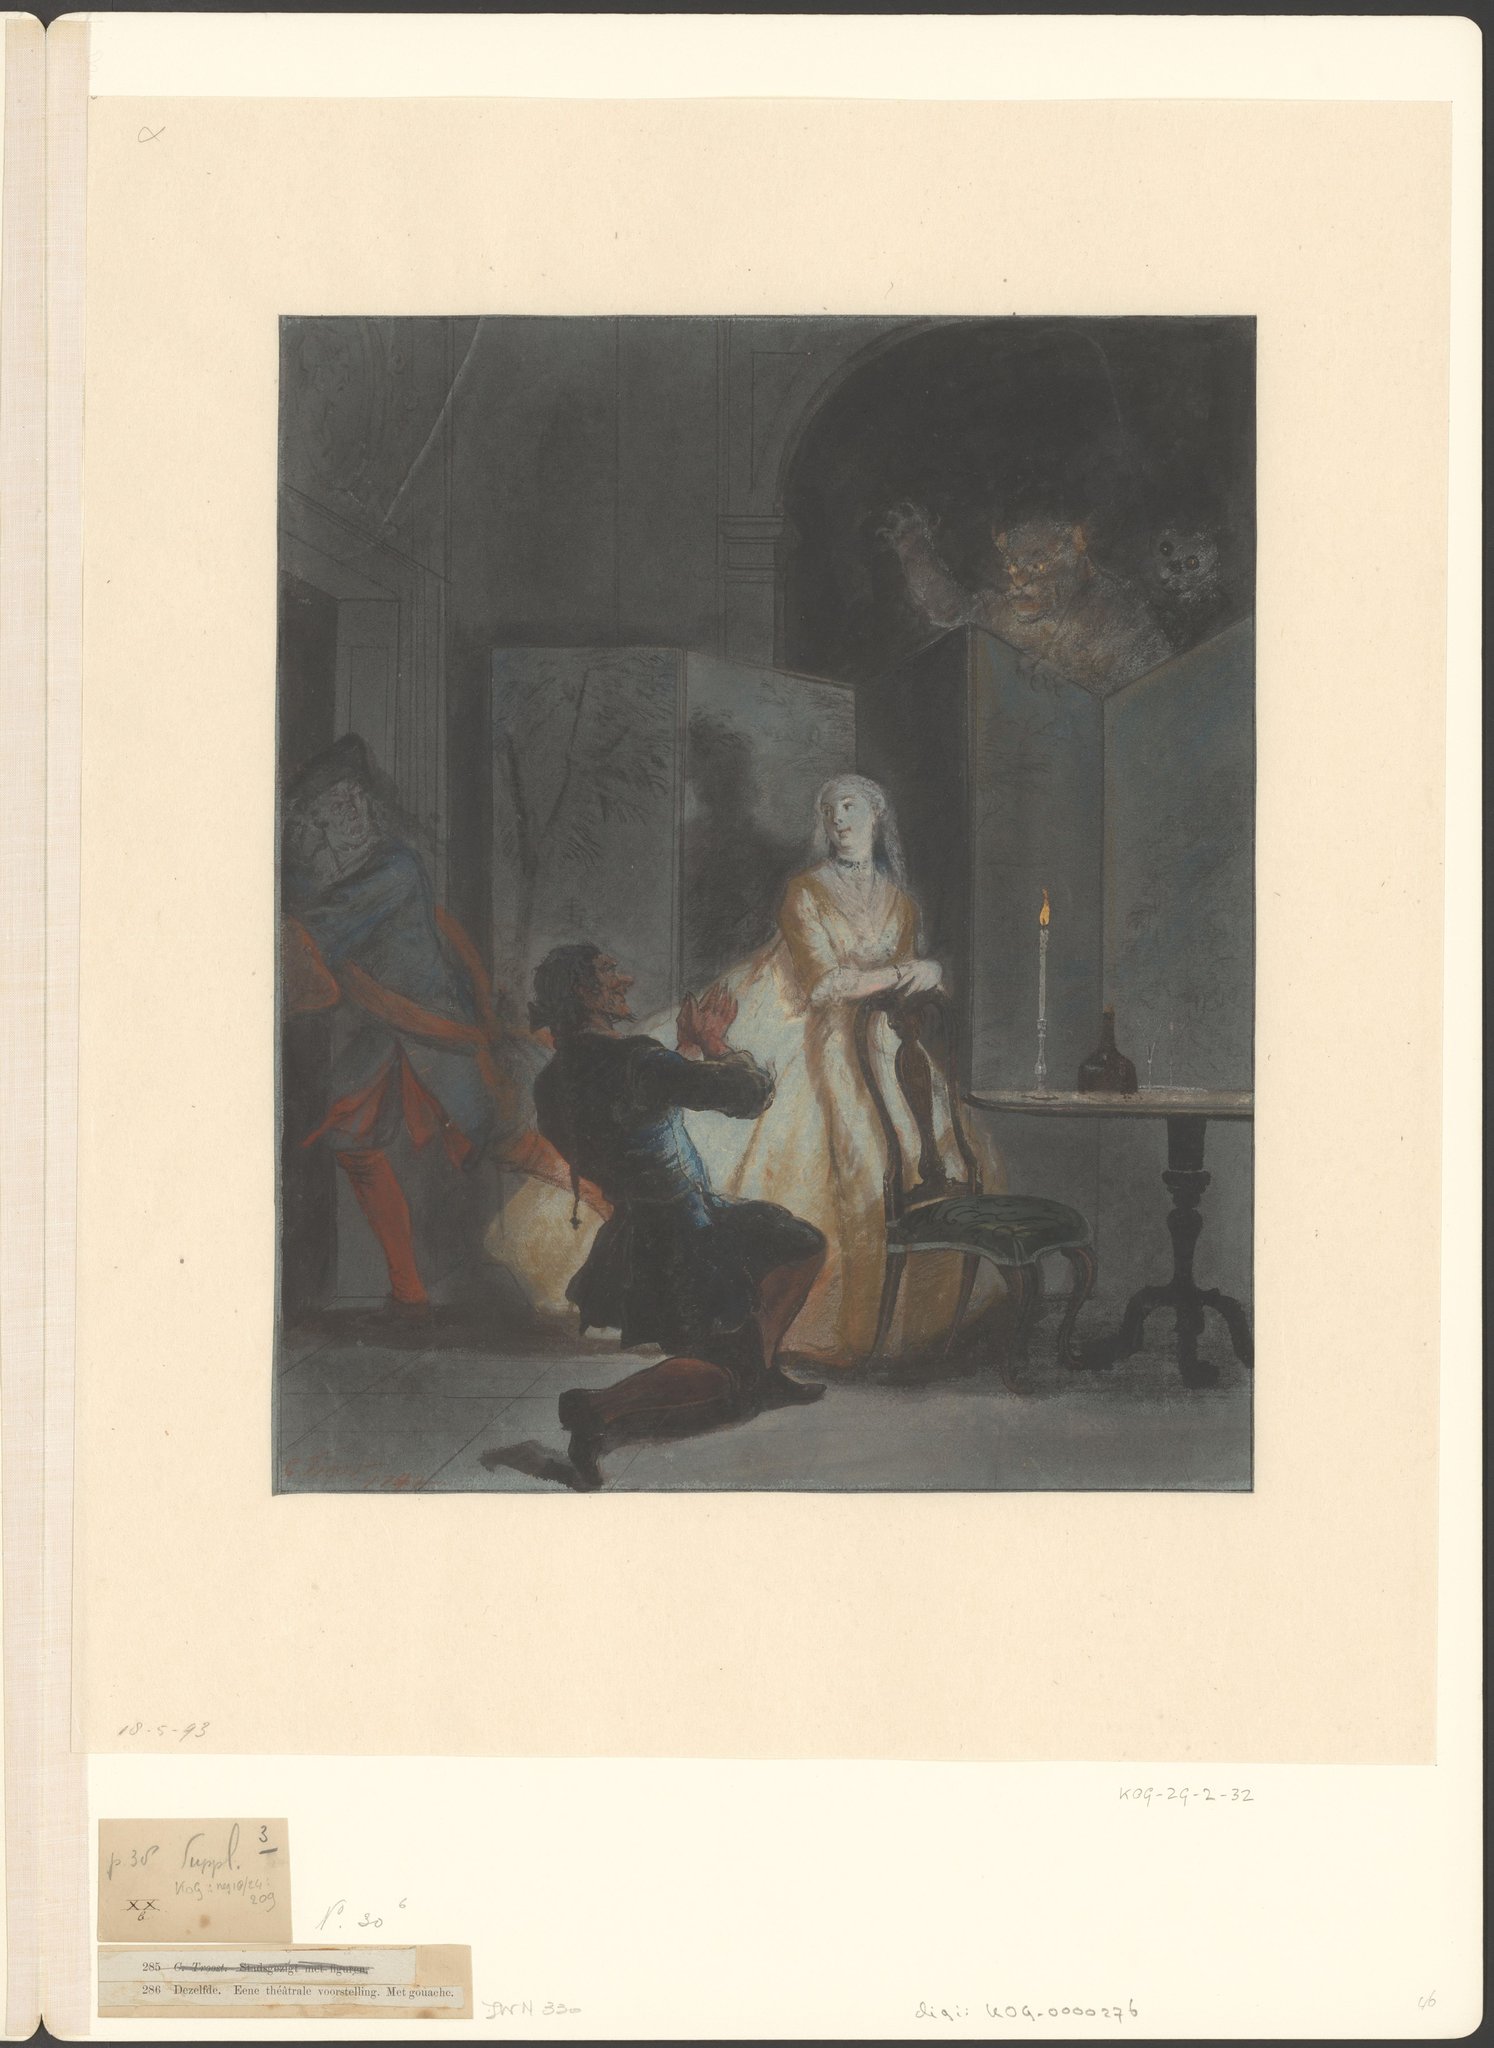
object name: drawing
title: Godefroy en zijn knecht jagen hopman Ulrich zijn huis uit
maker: cornelis troost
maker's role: draughtsman, painter, print maker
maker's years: 1696-1750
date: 1747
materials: chalk, gouache, paper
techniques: brush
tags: theatre, theatrical performance, dress, gown: ball gown, candle, glass of wine, beasts of prey, predatory animals: lion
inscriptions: collector's mark: Lugt 2488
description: De verklede Godefroy en zijn knecht jagen hopman Ulrich zijn huis uit. Ulrich houdt hier zijn vrouw Sybill opgesloten. Vijfde bedrijf uit Hopman Ulrich of de bedrogen gierigheid.